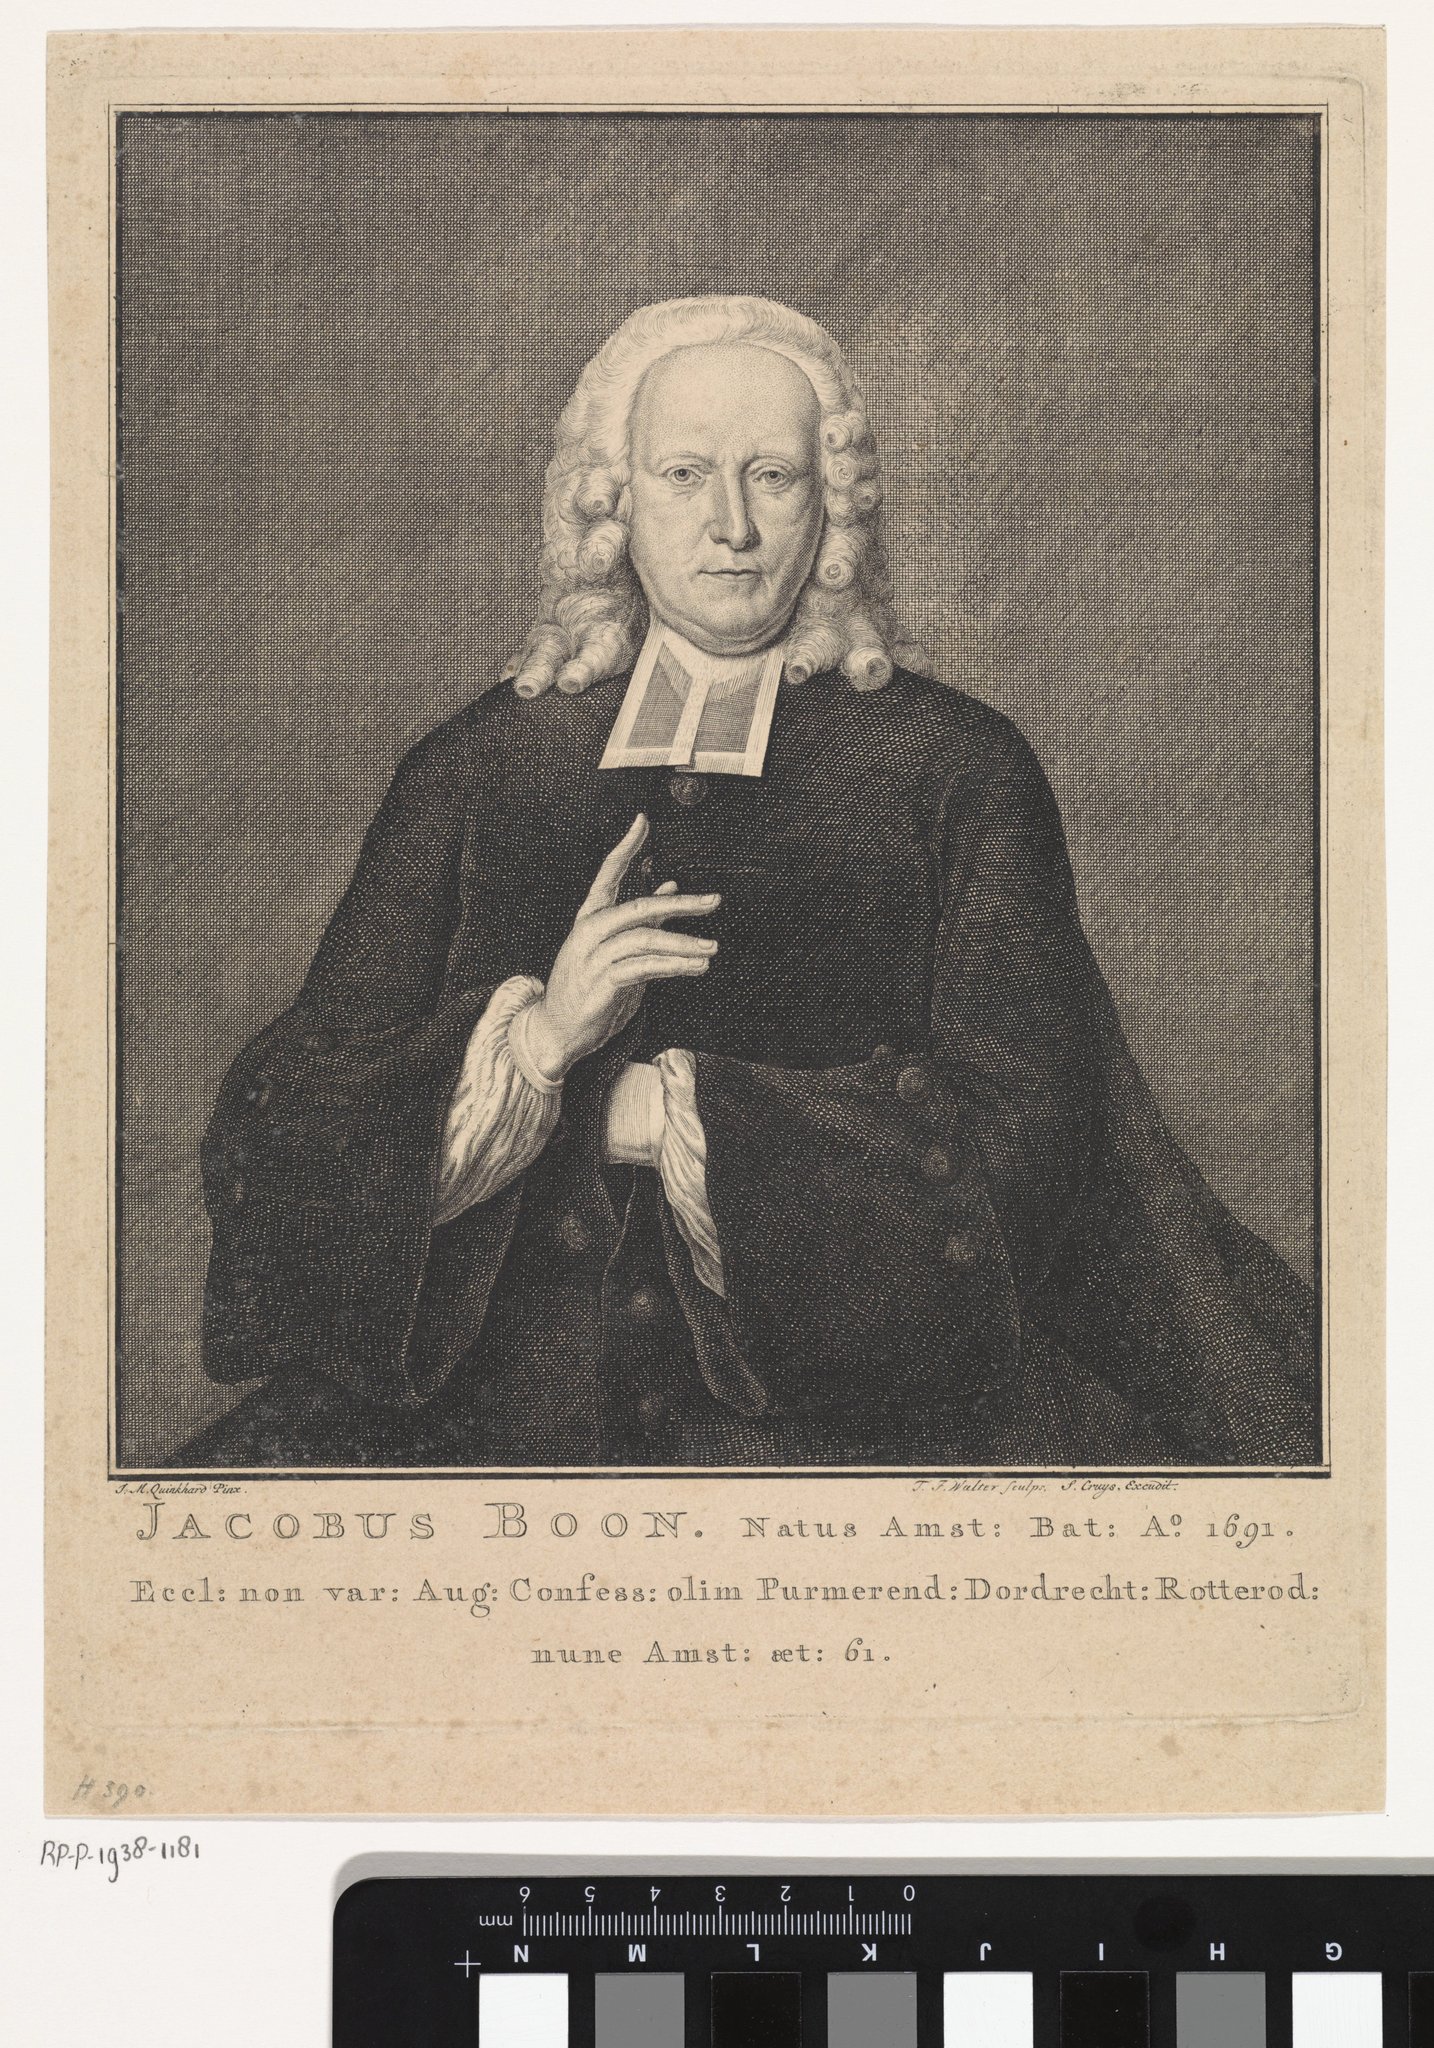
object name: print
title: Portret van predikant Jacobus Boon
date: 1738-1772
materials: paper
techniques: engraving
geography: northern netherlands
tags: amsterdam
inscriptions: collector's mark: Lugt 2760, collector's mark: Lugt 2228